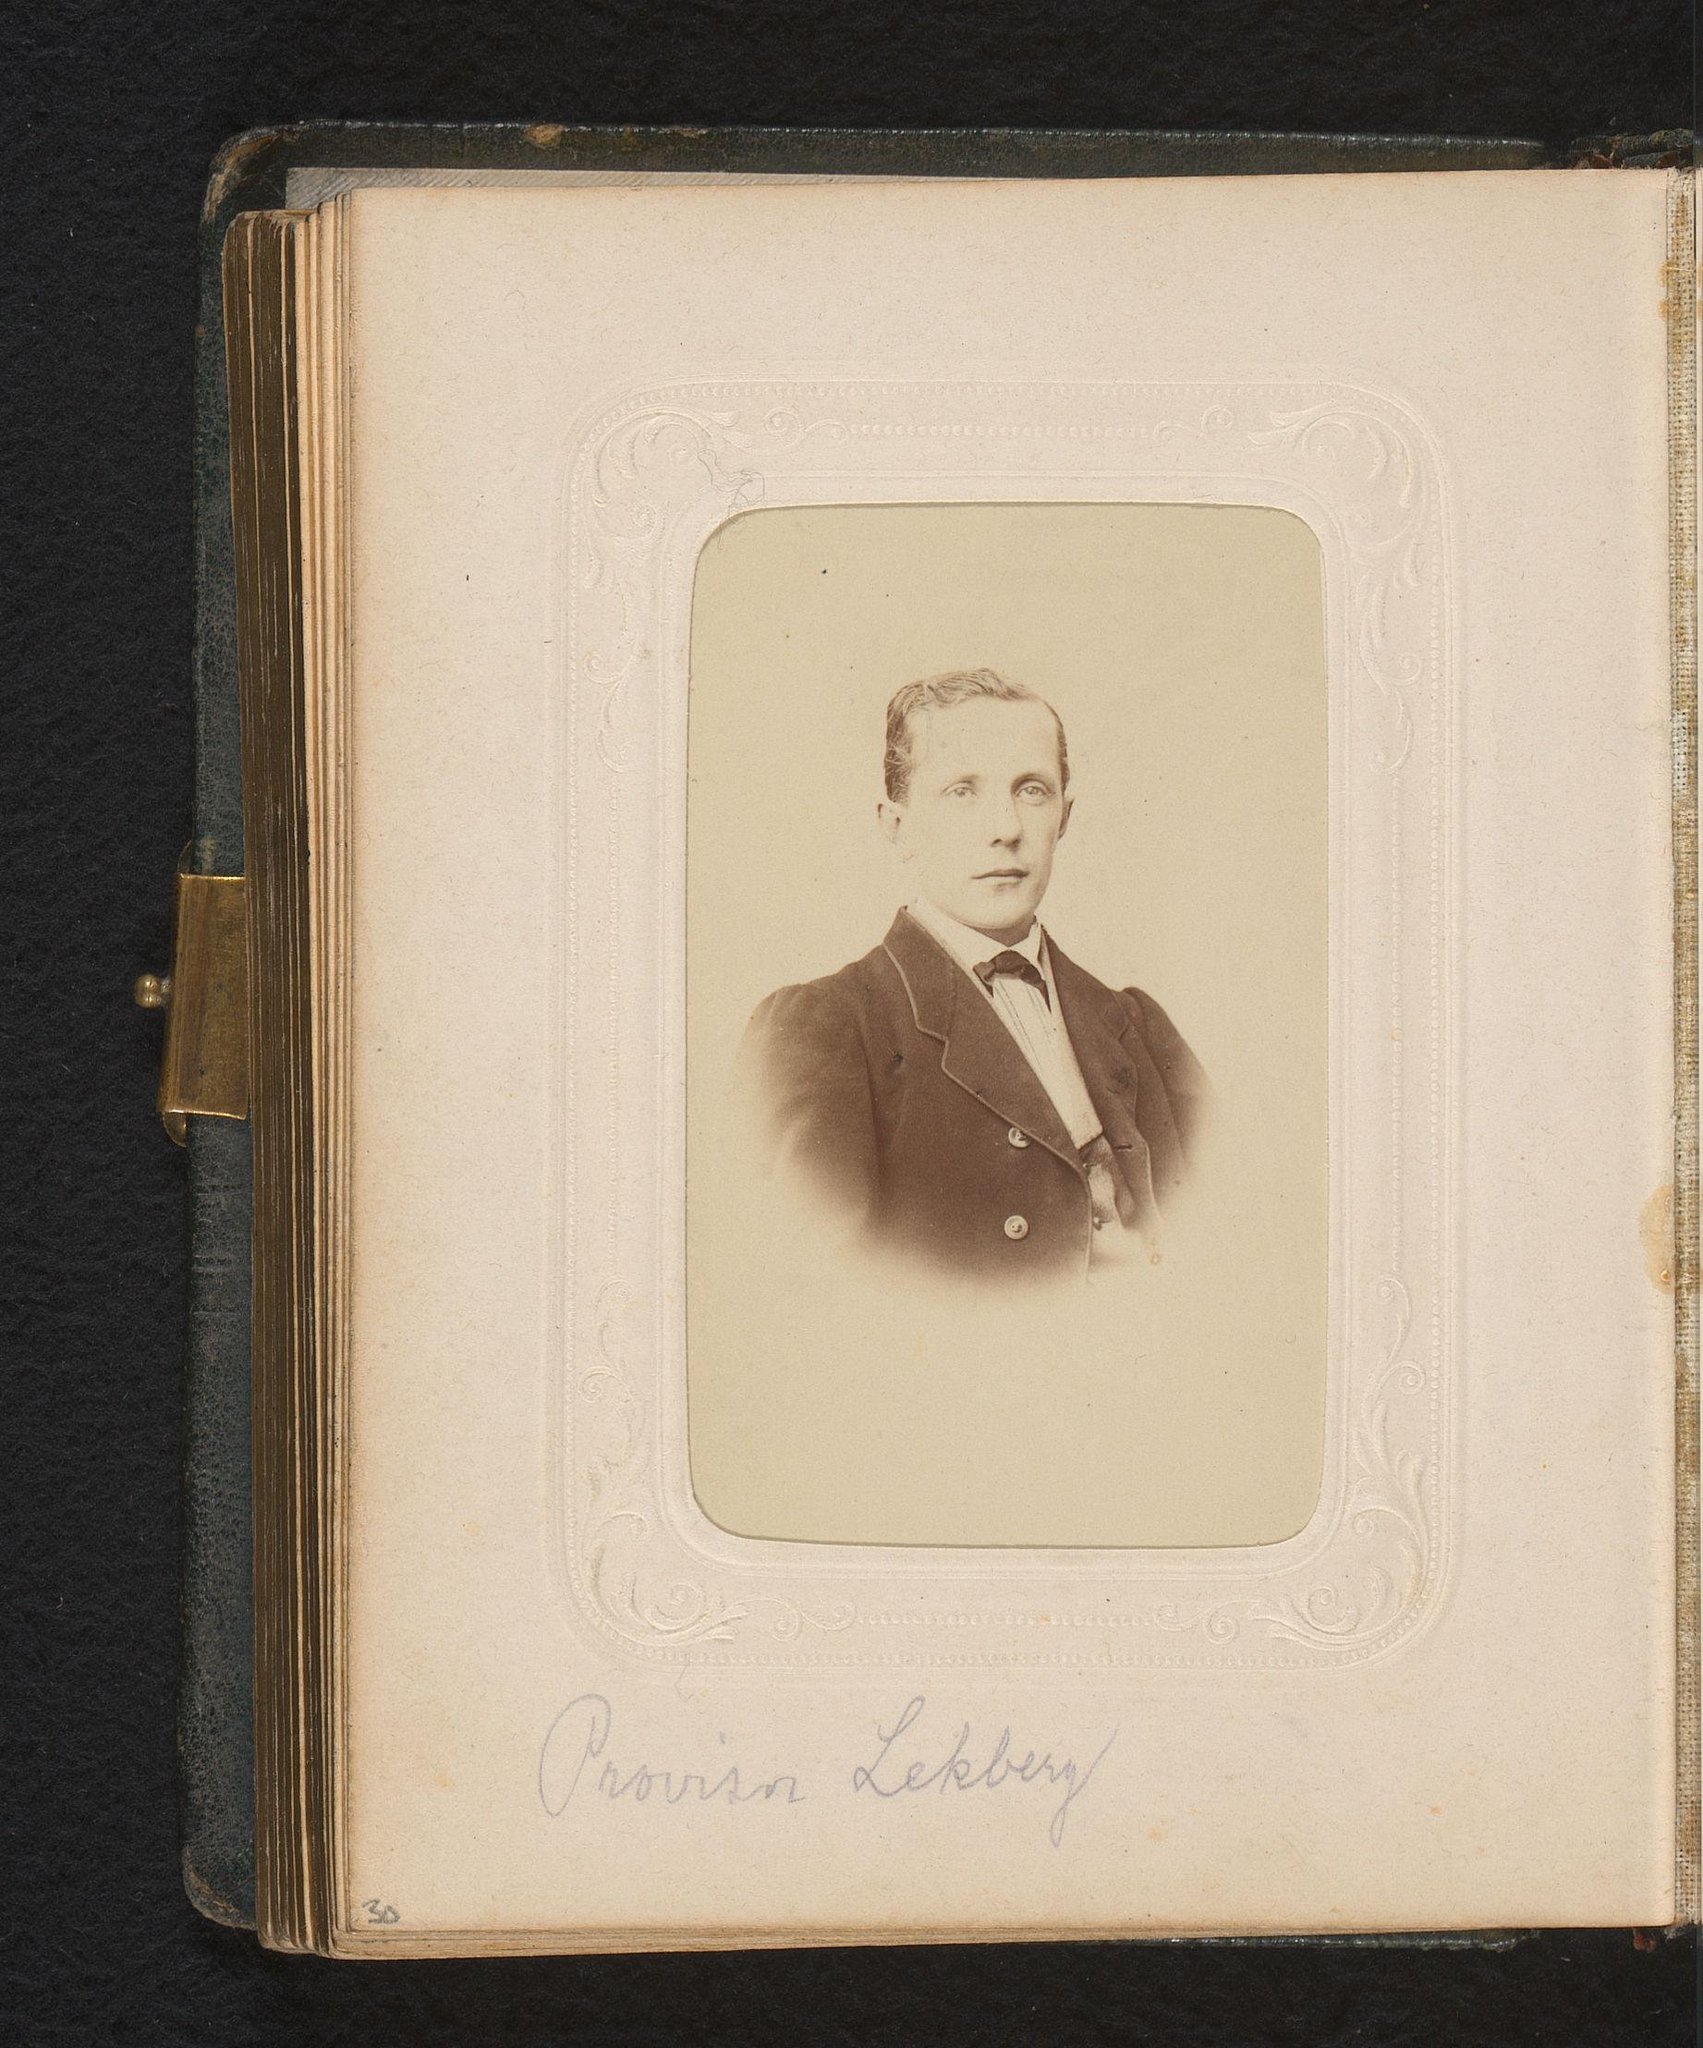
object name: photograph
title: Portret van een man, aangeduid als Proviser Lekberg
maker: august roesler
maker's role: fotograaf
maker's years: 1837-1896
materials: cardboard, photographic support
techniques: albumen print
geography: stockholm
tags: historical persons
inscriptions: name: ‘Proviser Lekberg’, inscription: ‘AUGUST ROESLER/ Drottninggatan No 23/ STOCKHOLM/ Samma hus som/ Apotheket Morian.’, annotation: ‘Proviser Lekberg’